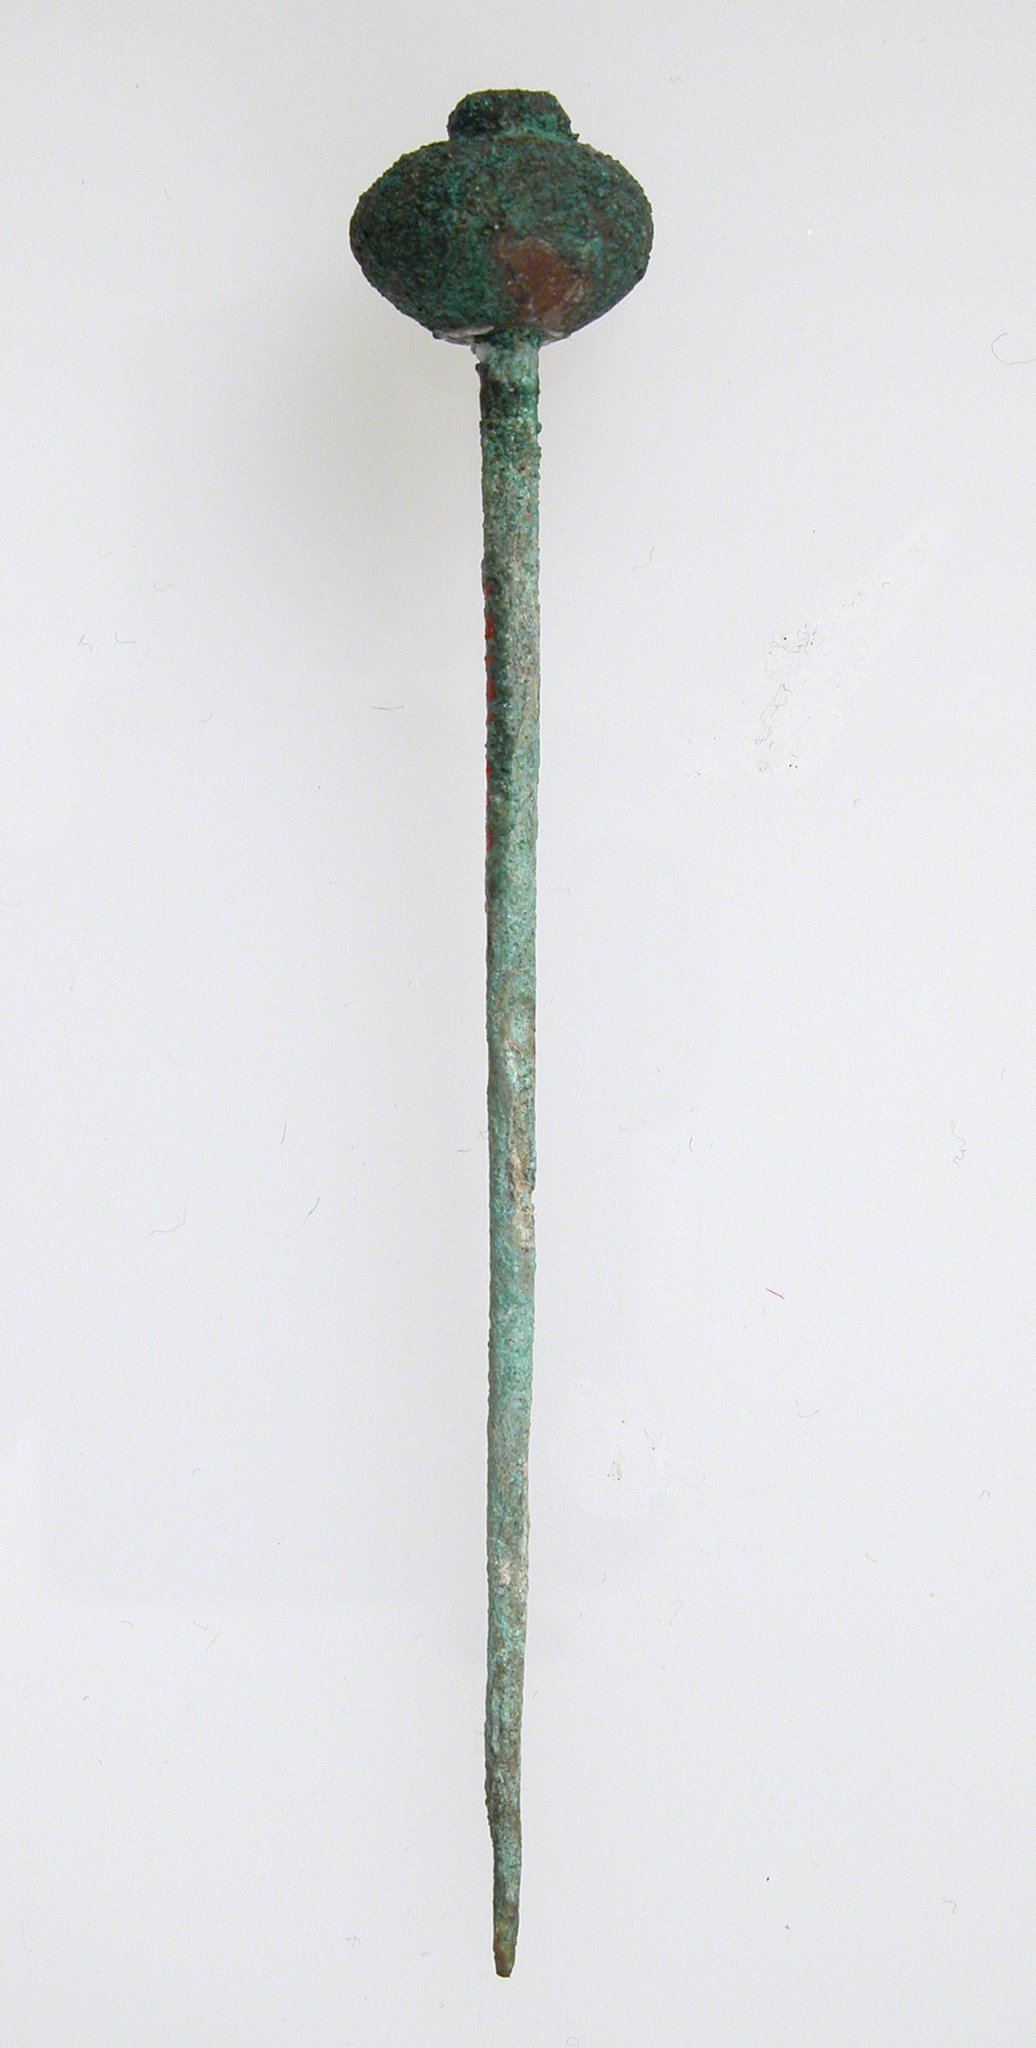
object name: hairpin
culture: roman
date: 200-500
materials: copper alloy